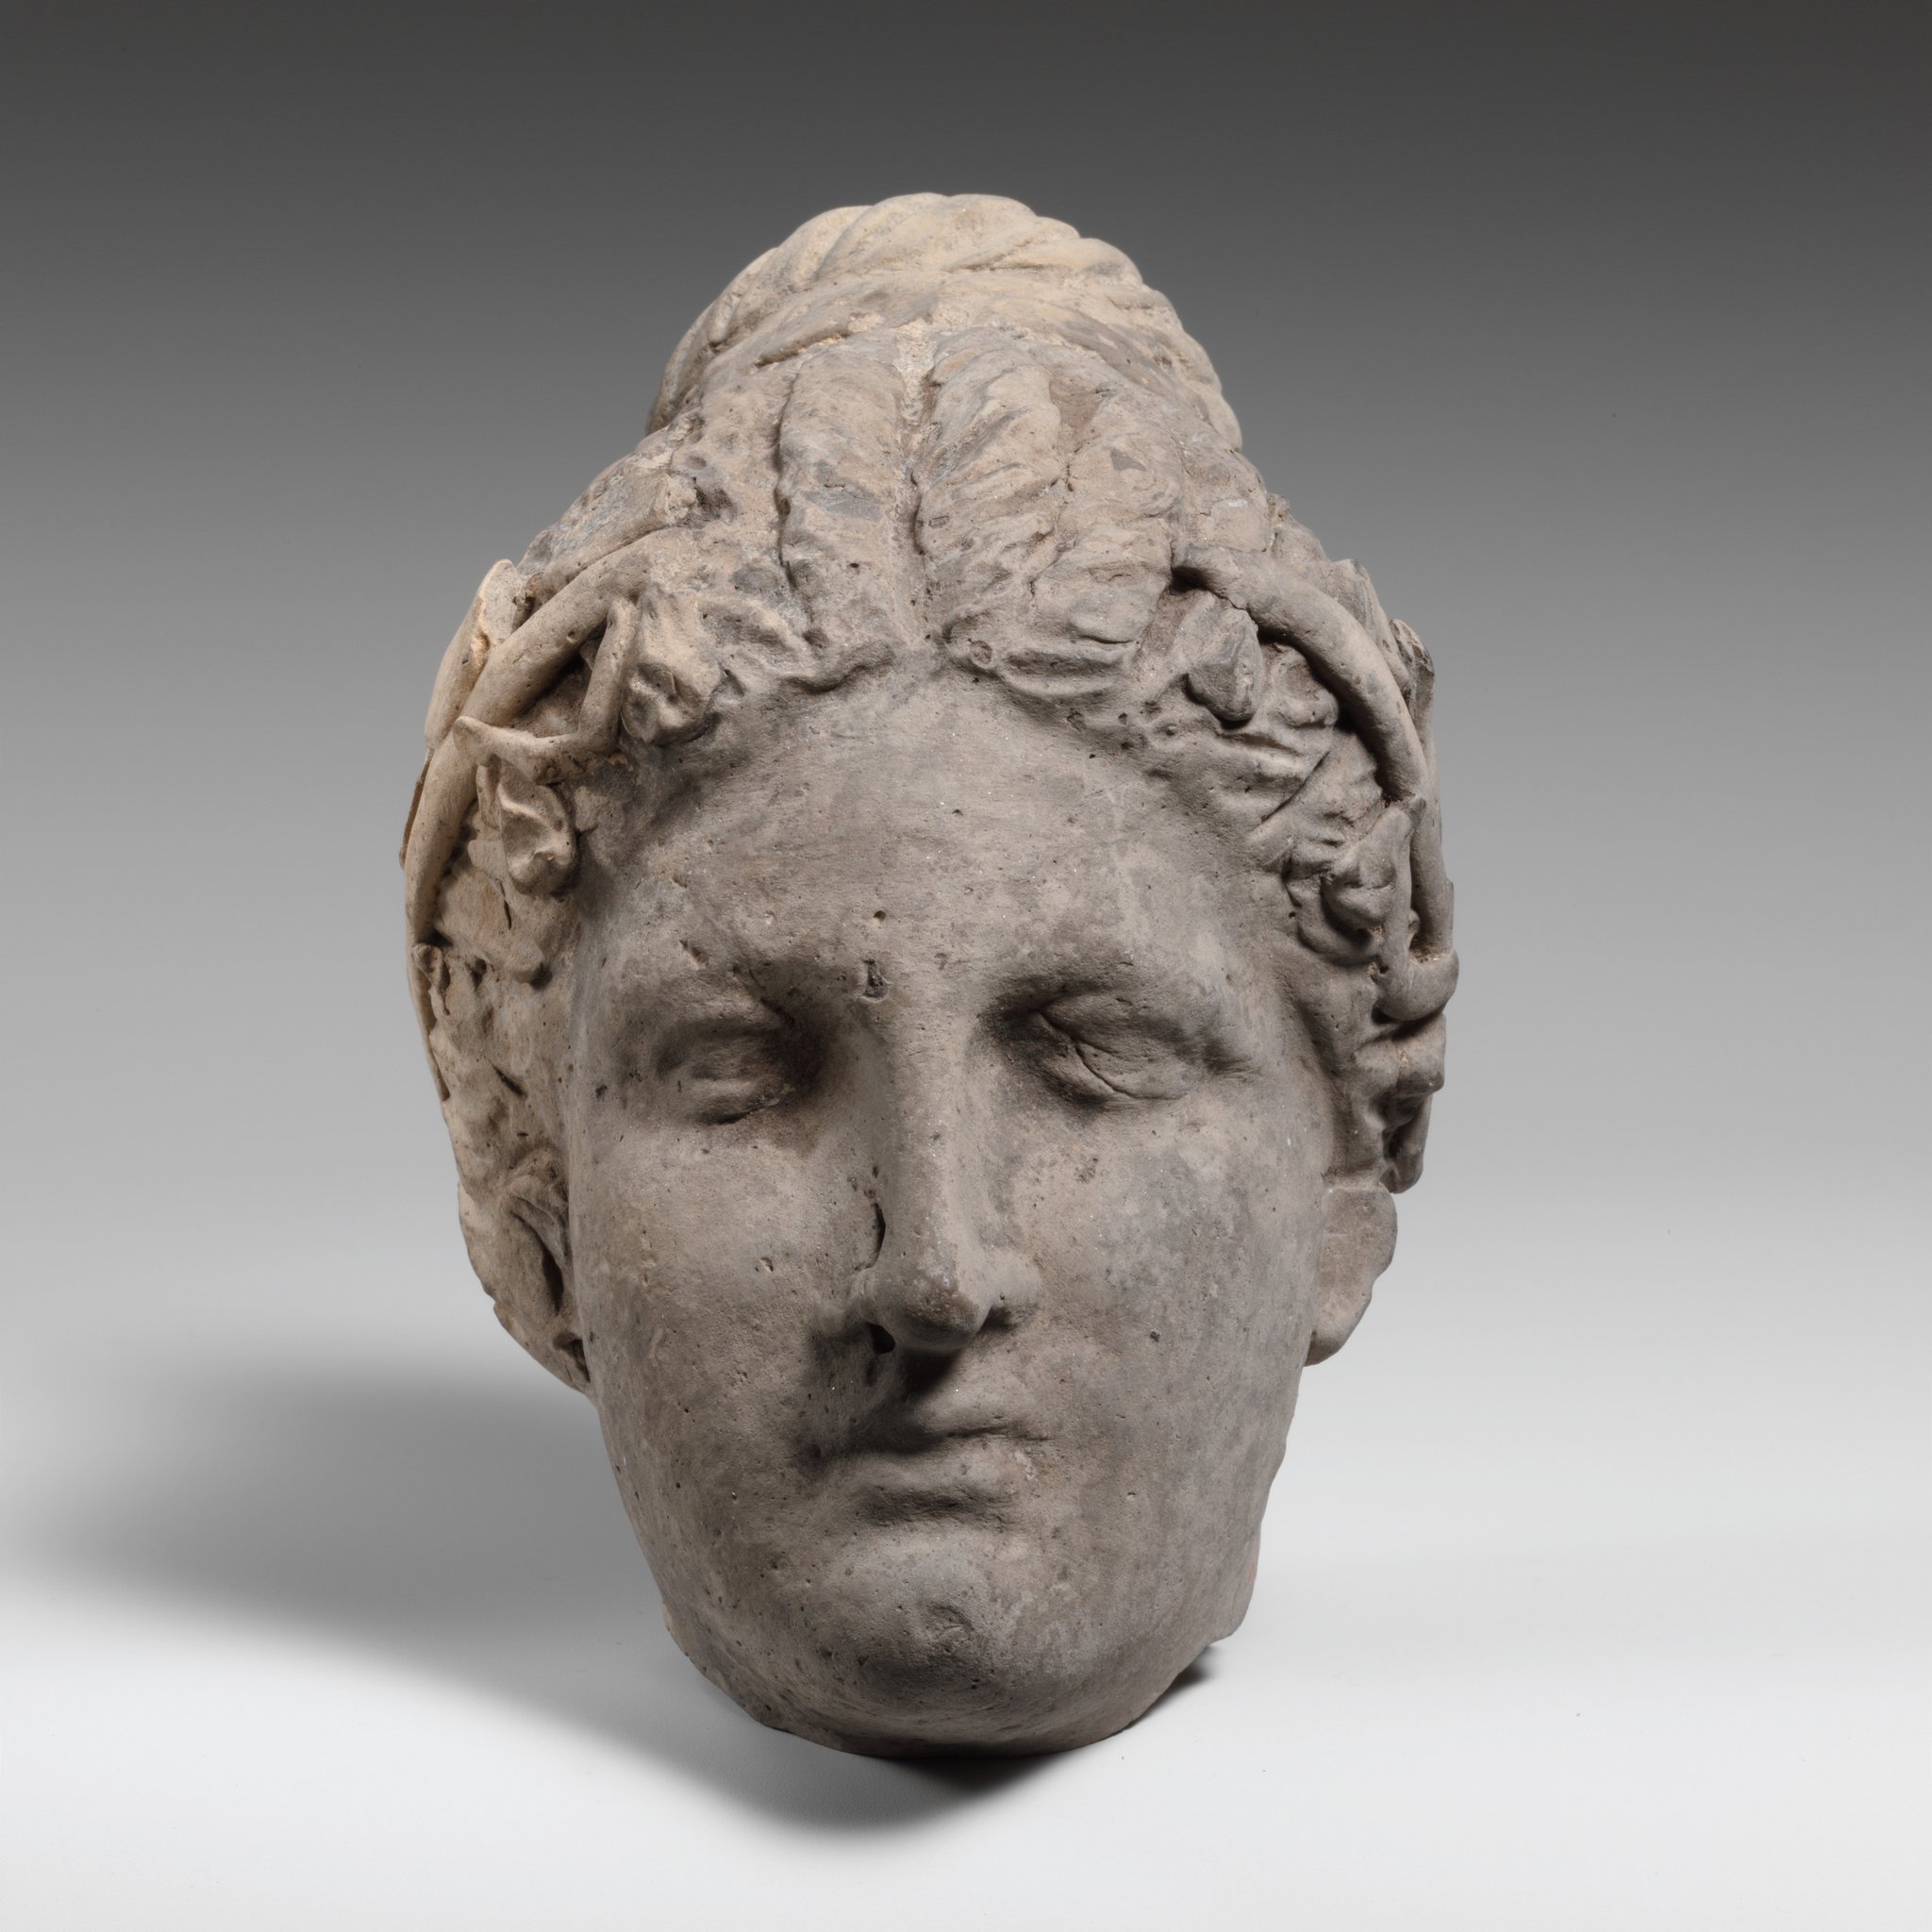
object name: head of a woman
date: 7000 BCE-330 CE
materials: terracotta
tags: heads,women